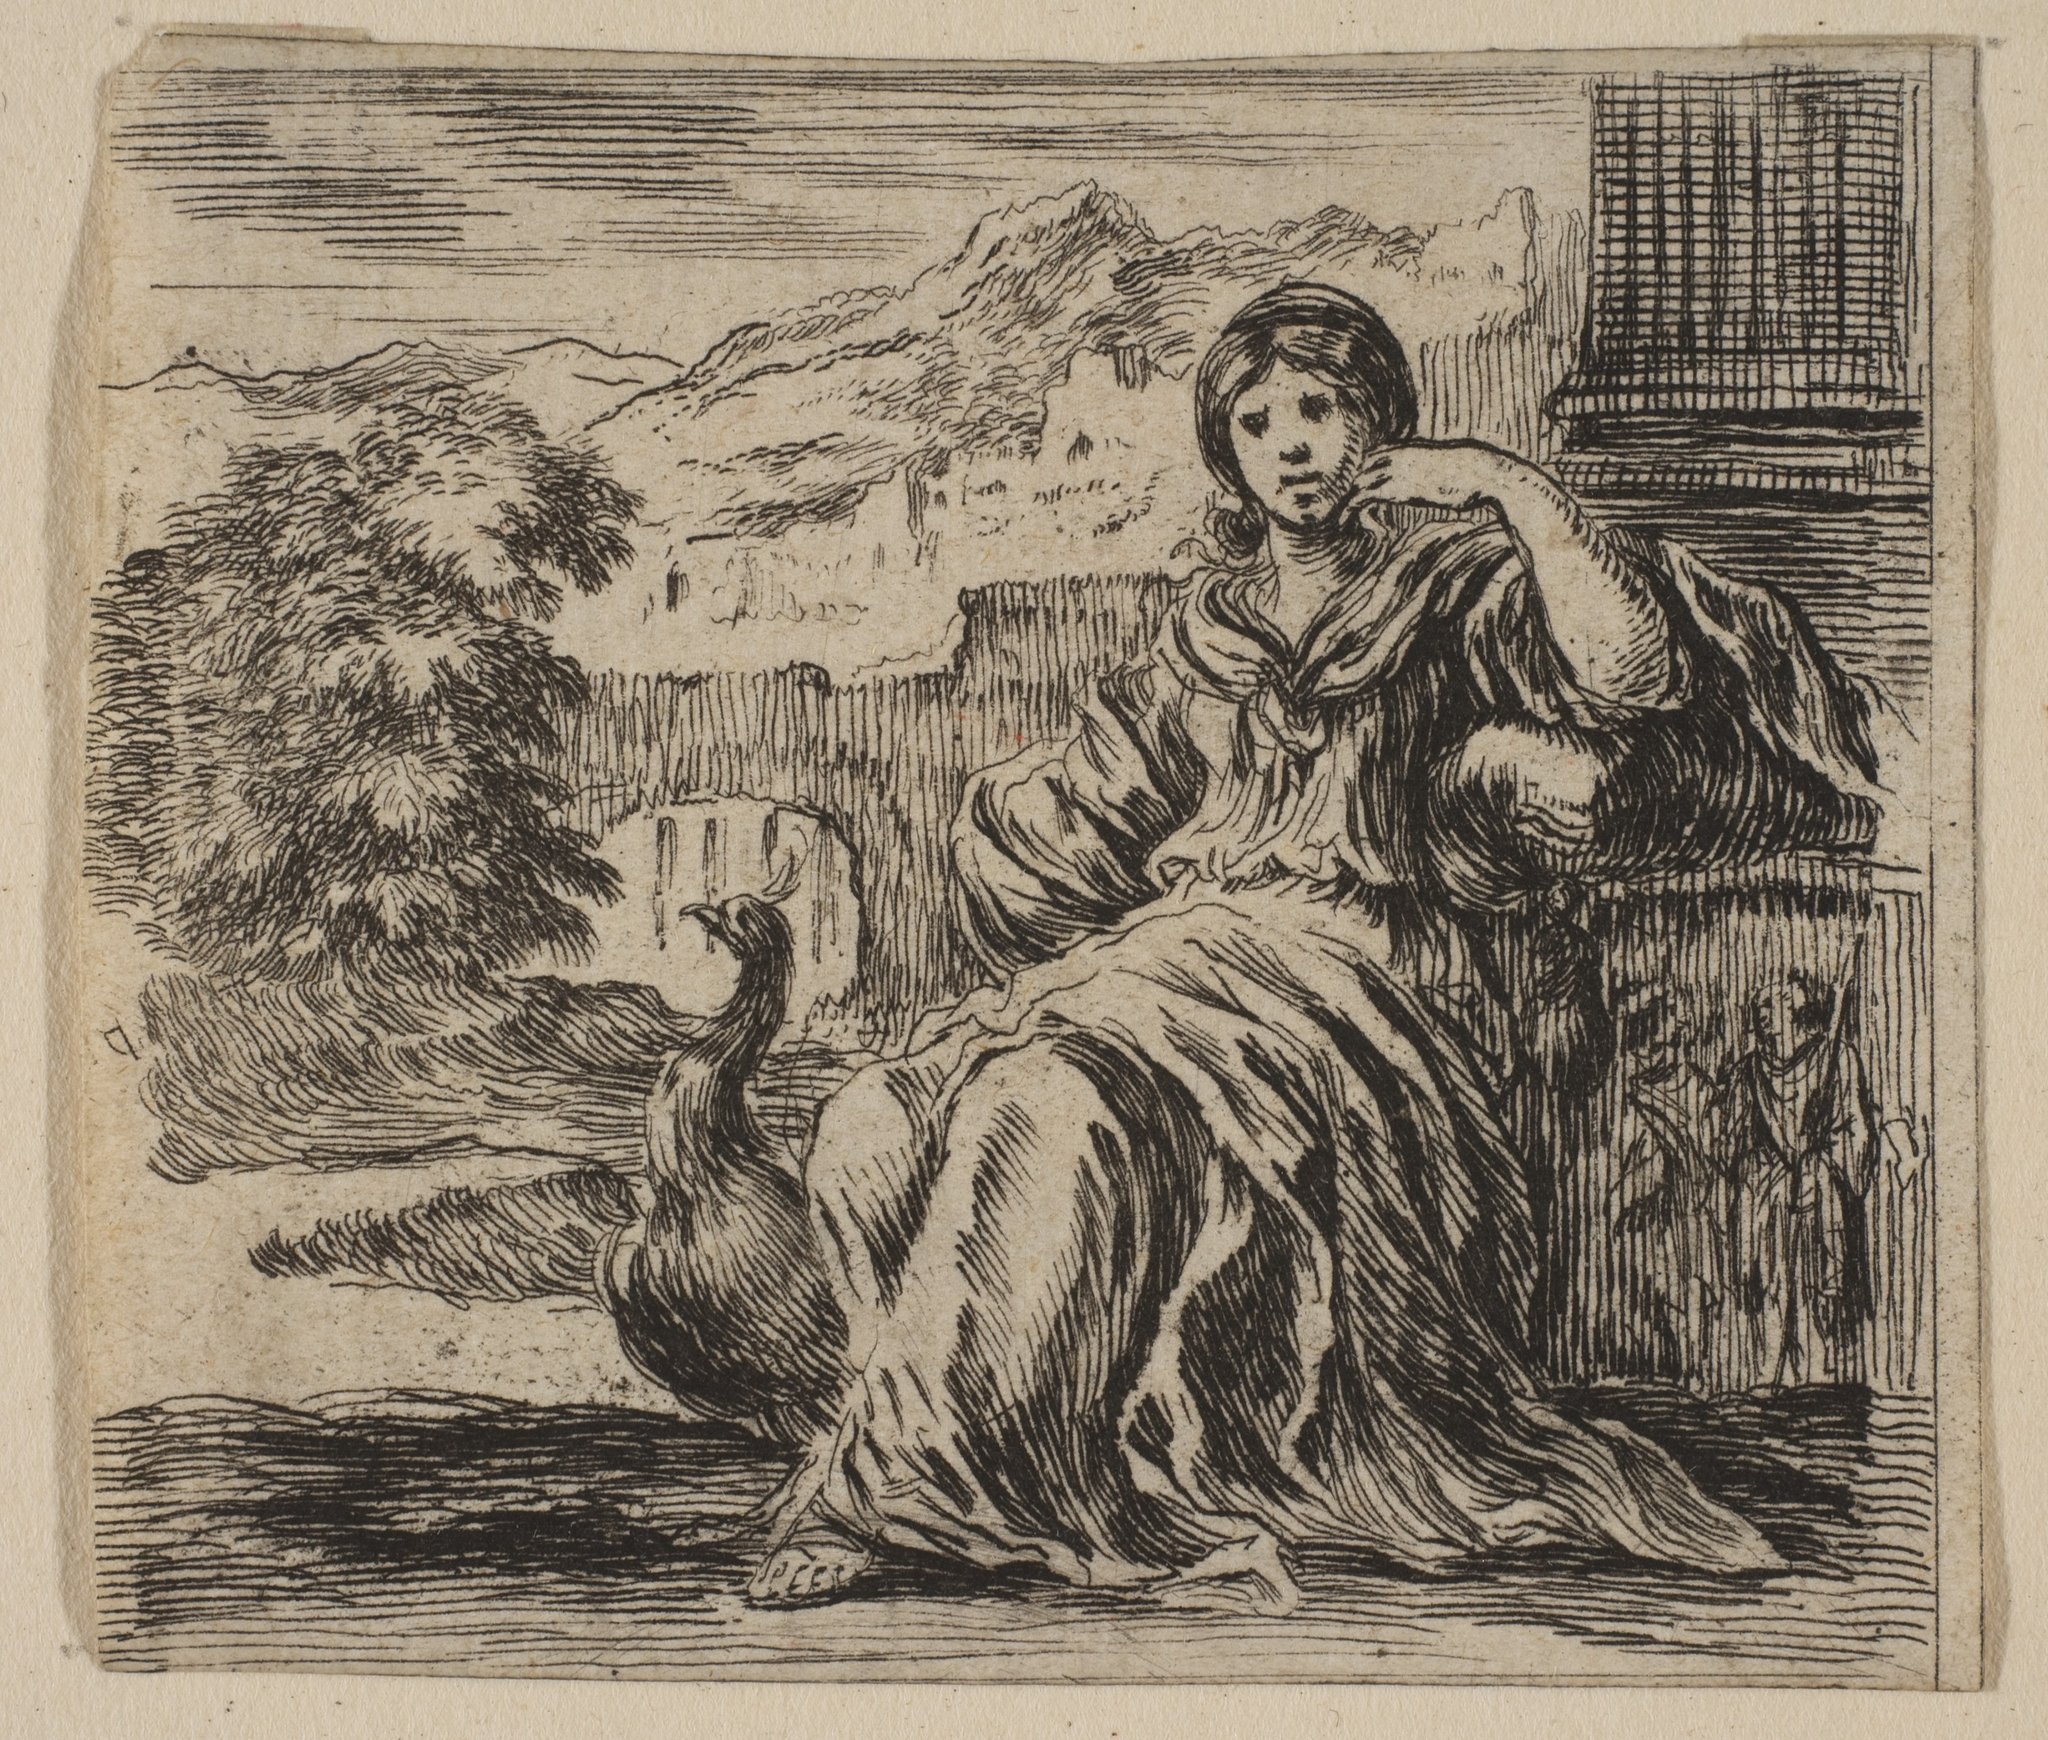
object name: print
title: Juno, from 'Game of Mythology' (Jeu de la Mythologie)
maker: stefano della bella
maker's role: artist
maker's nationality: italian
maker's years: 1610-1664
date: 1644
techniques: etching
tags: juno,peacocks,mountains,trees